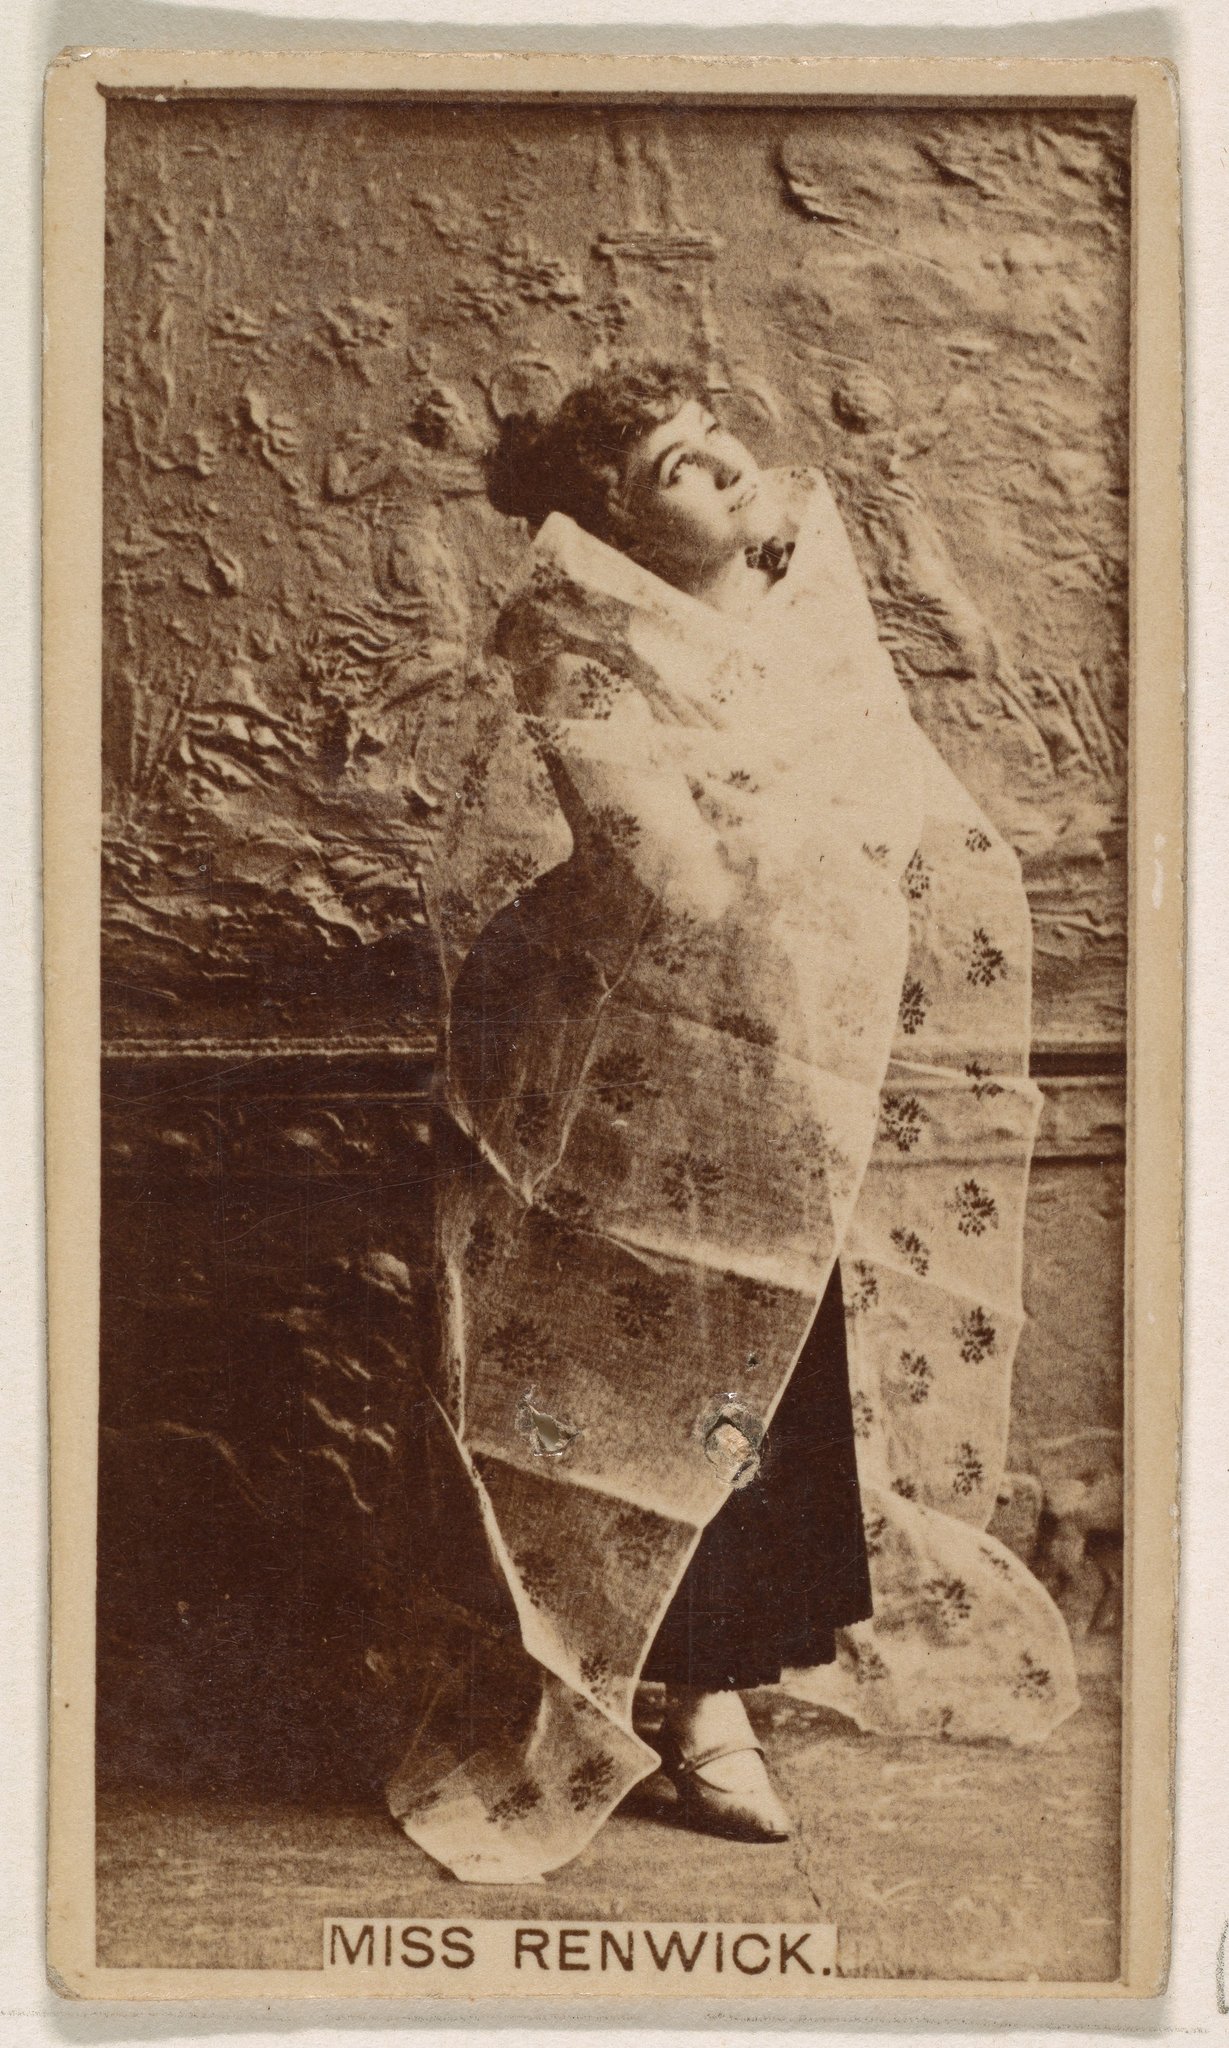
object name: photograph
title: Miss Renwick, from the Actresses series (N245) issued by Kinney Brothers to promote Sweet Caporal Cigarettes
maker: kinney brothers tobacco company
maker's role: publisher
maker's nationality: american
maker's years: 1869-2011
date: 1890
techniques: albumen silver print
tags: portraits,women,actresses